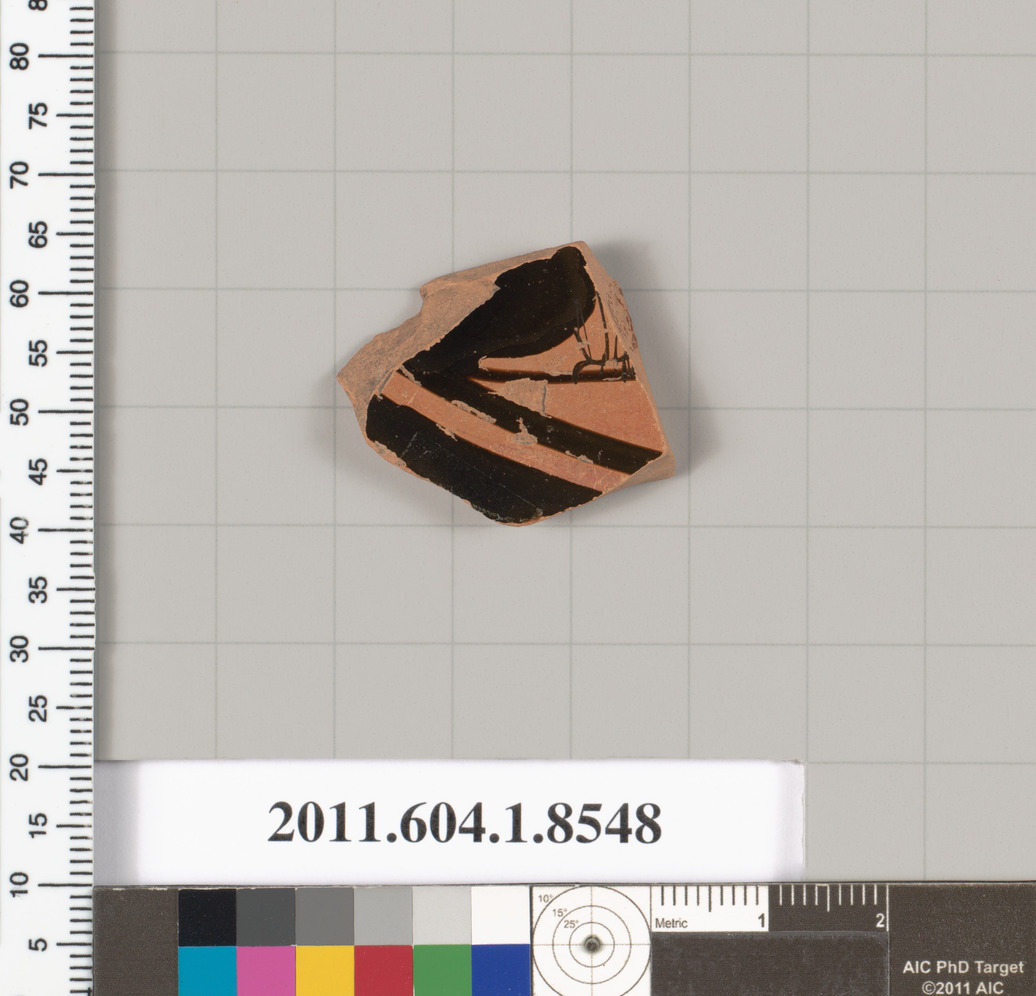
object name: kylix fragment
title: Terracotta fragment of a stemless kylix? (drinking cup)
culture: greek, attic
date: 460-450 BCE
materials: terracotta